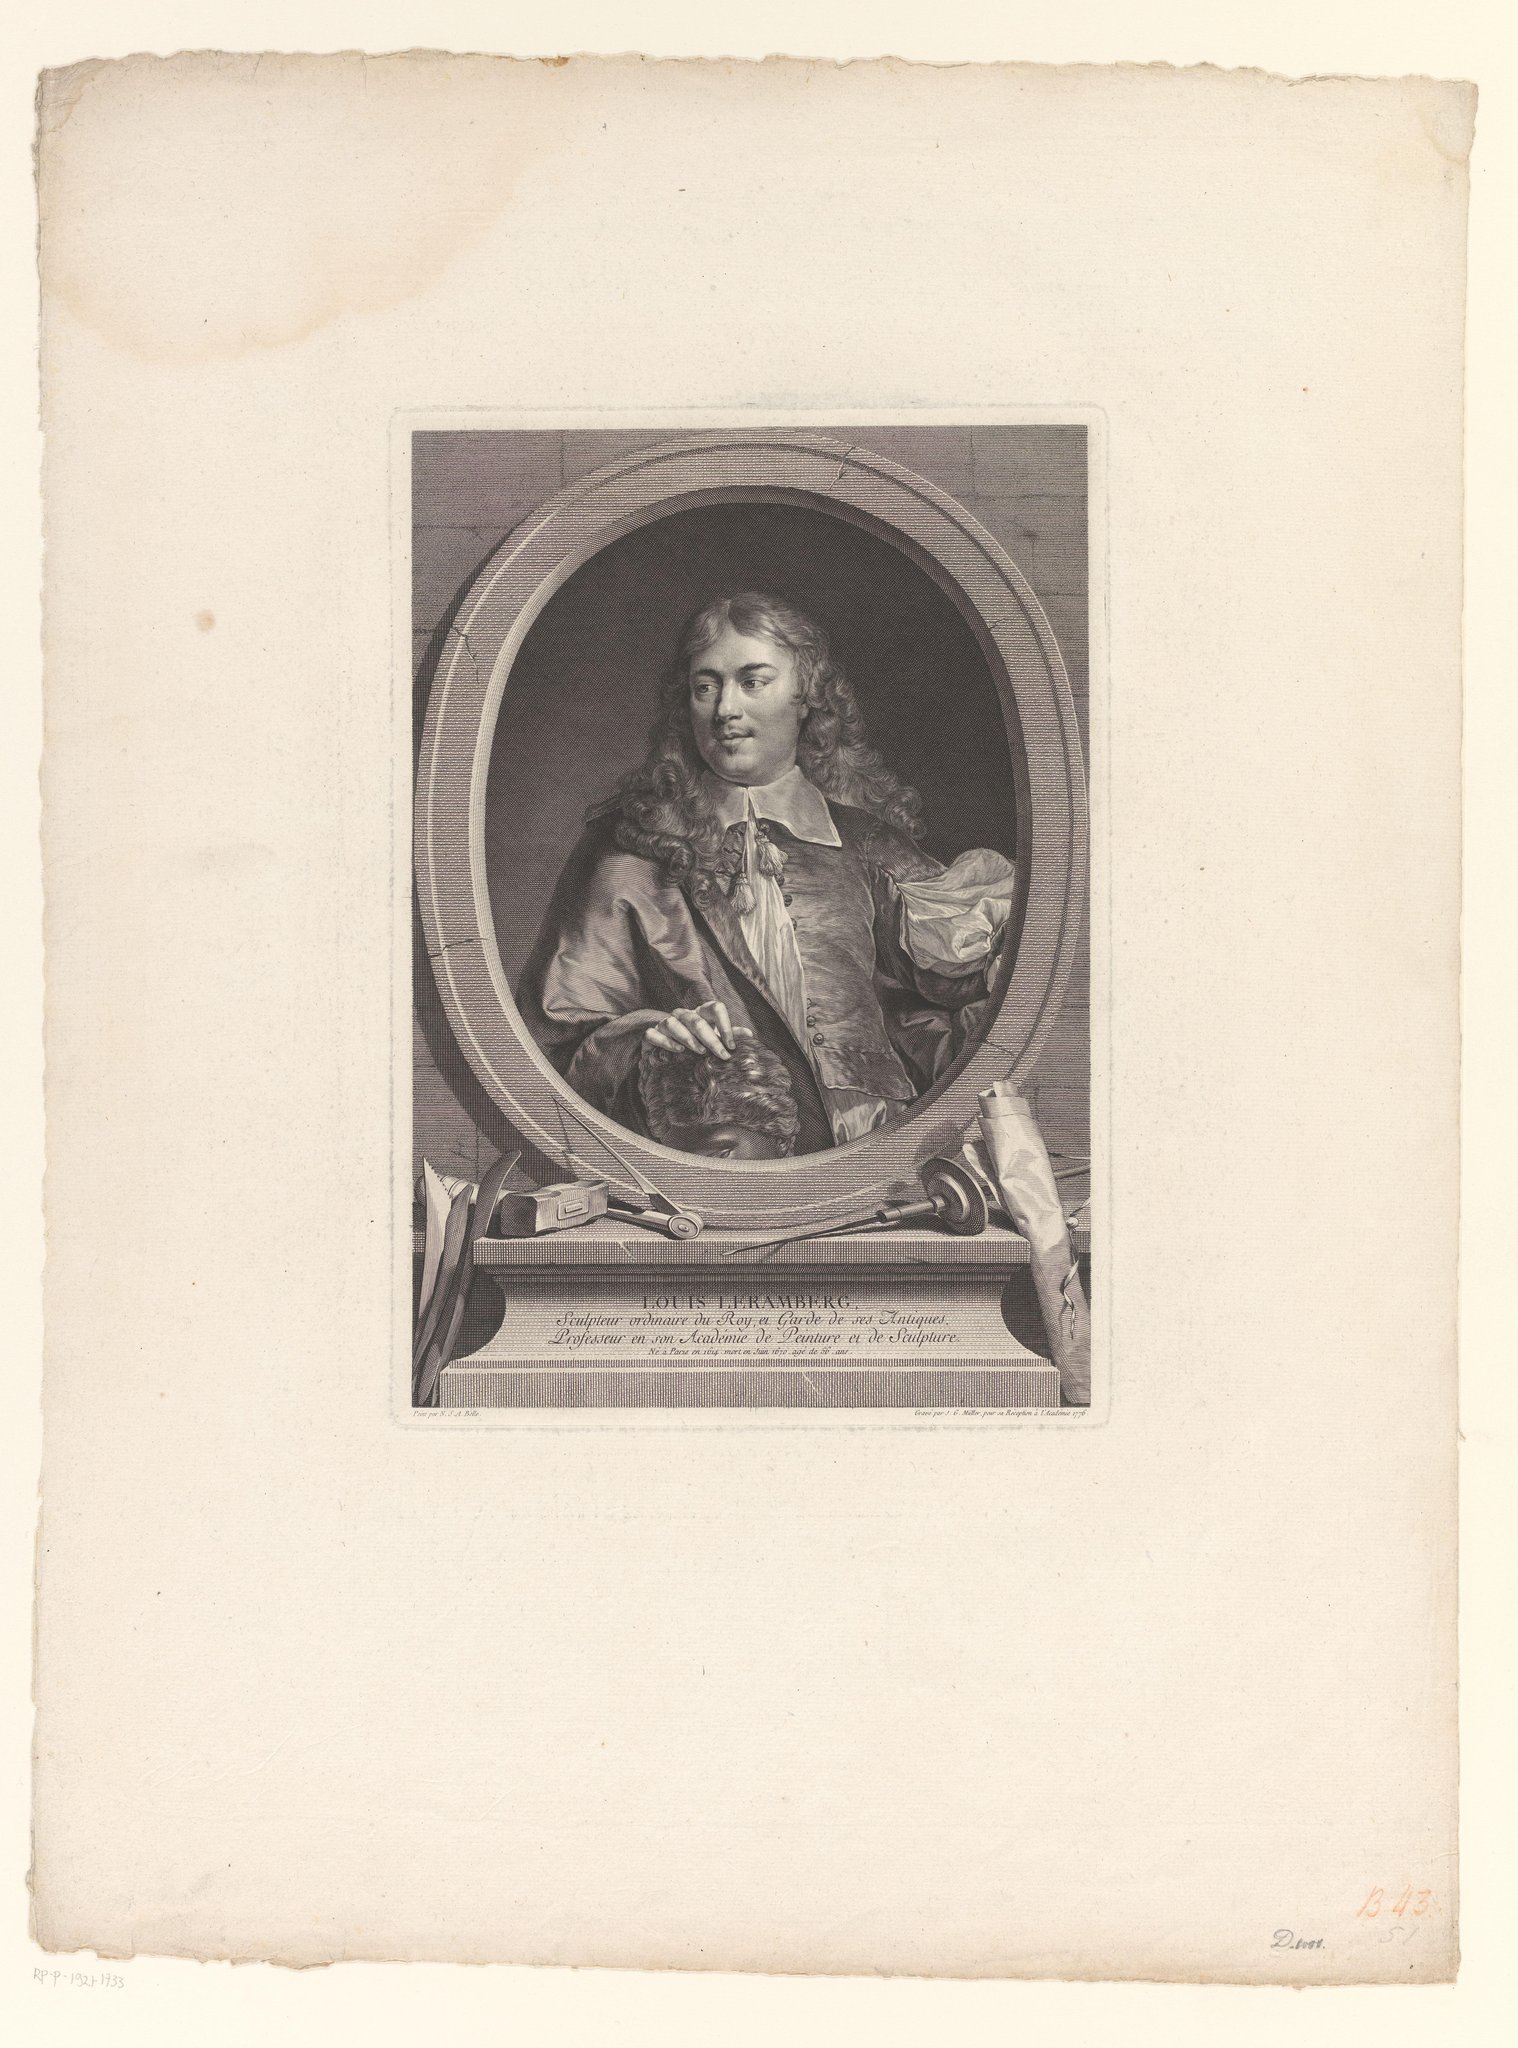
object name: print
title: Portret van Louis Lerambert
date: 1776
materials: paper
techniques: engraving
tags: paris, louis lerambert, portrait, self-portrait of sculptor, historical persons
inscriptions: collector's mark: Lugt 2233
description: Deze prent is gemaakt als onderdeel van Johann Gotthard von Müllers toelating tot de kunstacademie in Parijs.